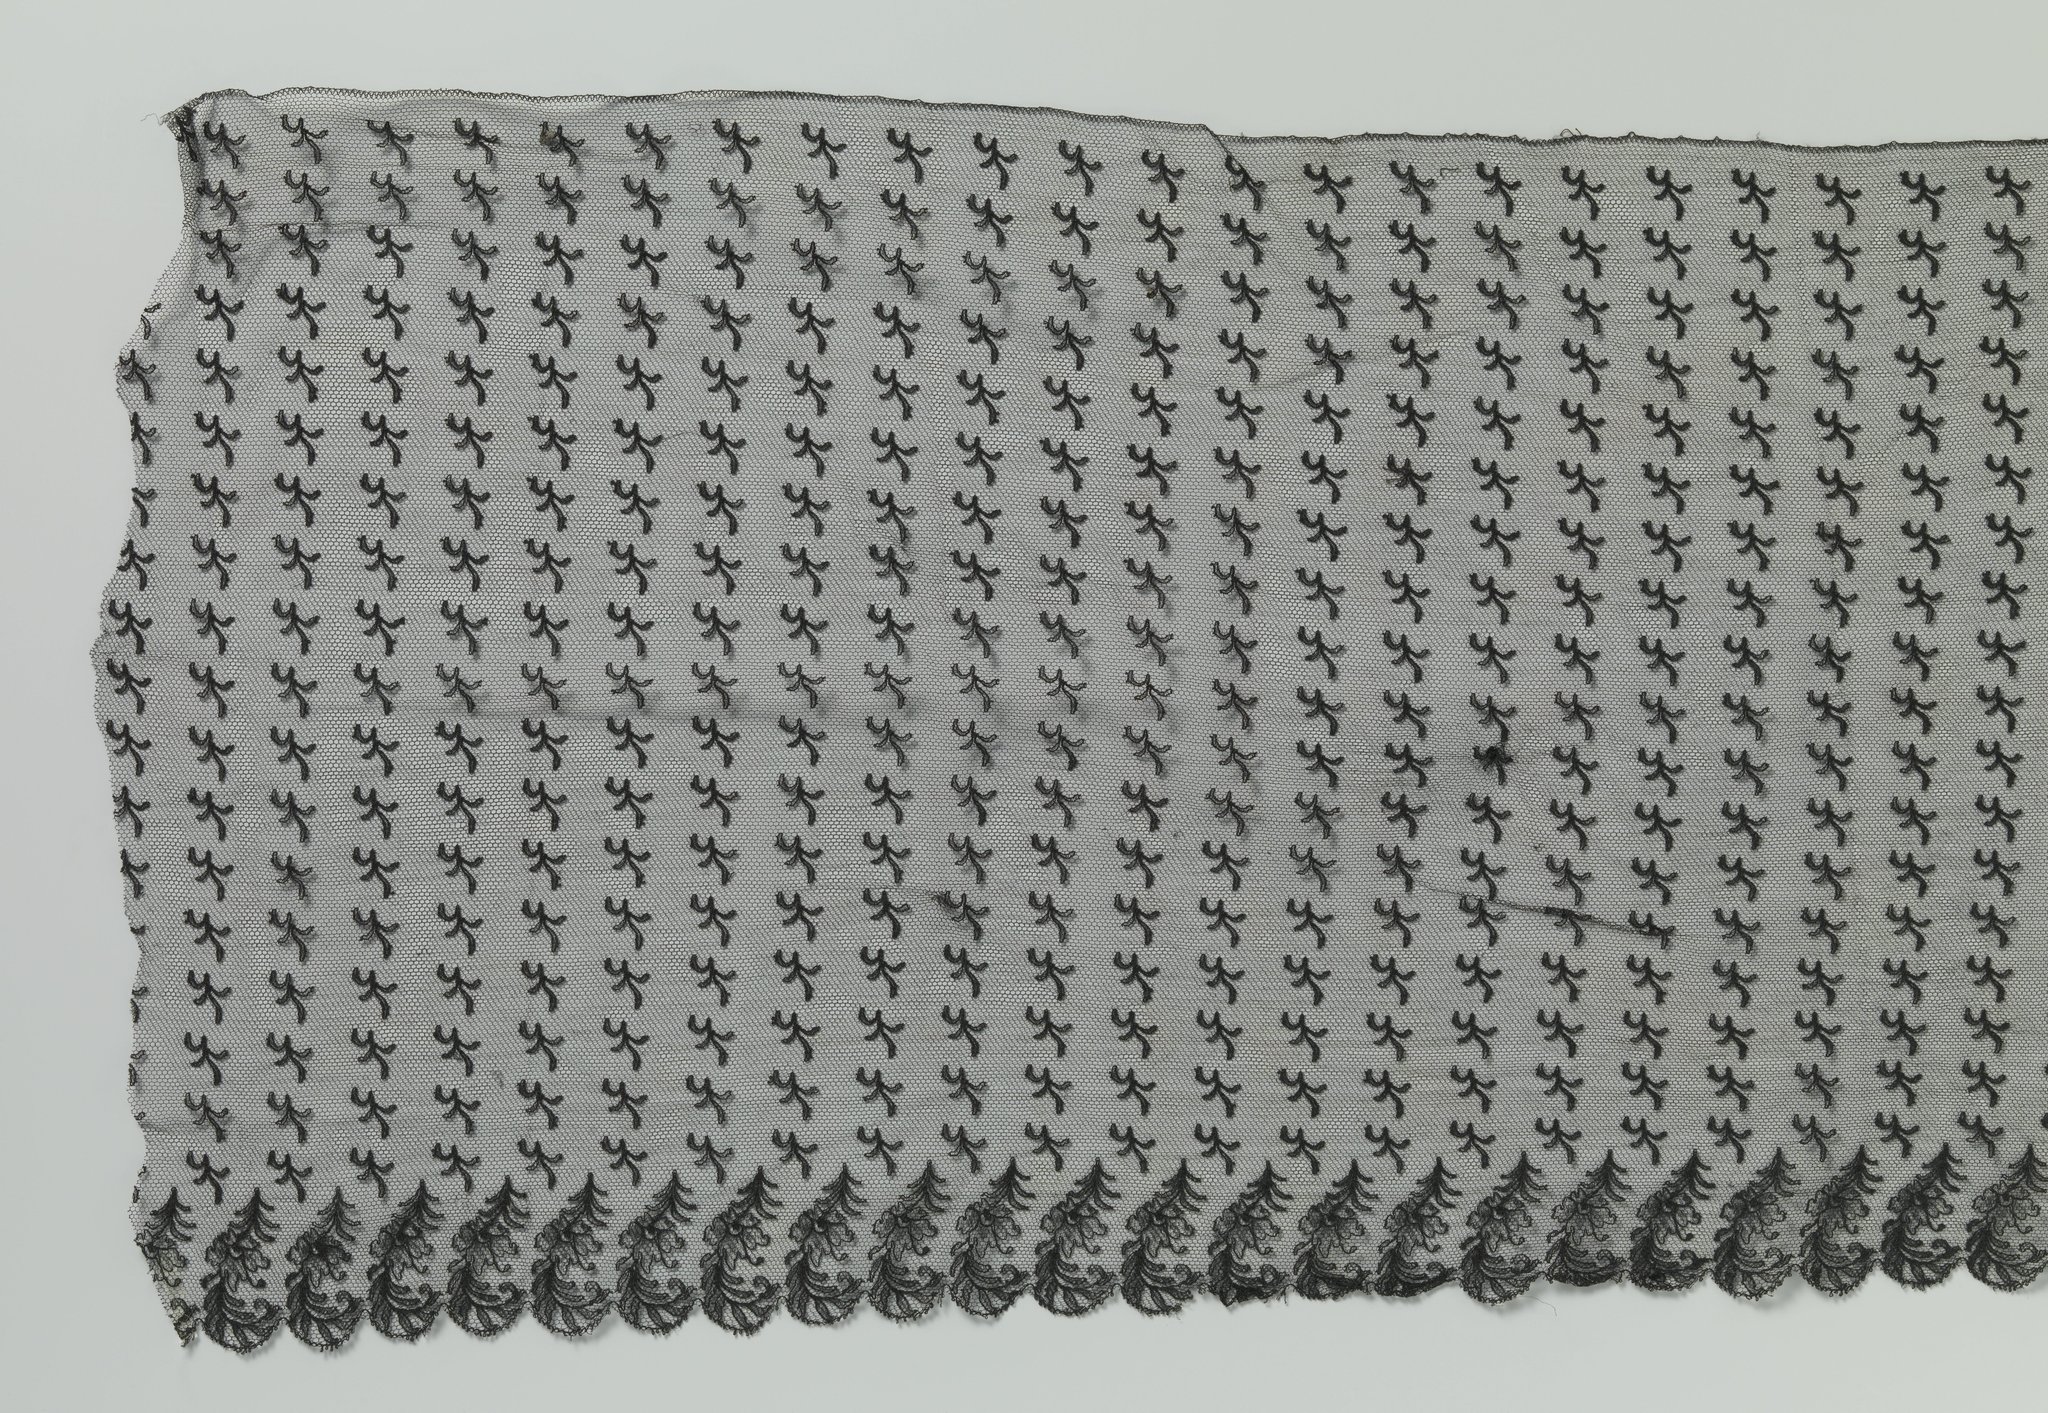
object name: strip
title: Strook zwarte machinale kant met een onderzijde van j-vormige gevederde bladeren met bloem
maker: Anonymous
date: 1885-1895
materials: cotton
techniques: lace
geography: calais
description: Strook zwarte machinale kant: machinale Chantilly-kant. Het zich herhalende patroon bestaat uit achttien rijen recht onder elkaar geplaatste takjes en een rij hangende gevederde bladeren met steeds één bloem langs de onderrand. De gevederde bladeren hangen als een j naar beneden, de bloem bevindt zich halverwege de stok van de j en oversnijdt het blad. De bochten van de j-vormige bladeren vormen de schulpenrand langs de onderzijde van de strook, die is afgewerkt met picots. De bovenzijde van de strook is recht afgewerkt. De korte zijden zijn meer of minder schuin afgeknipt.